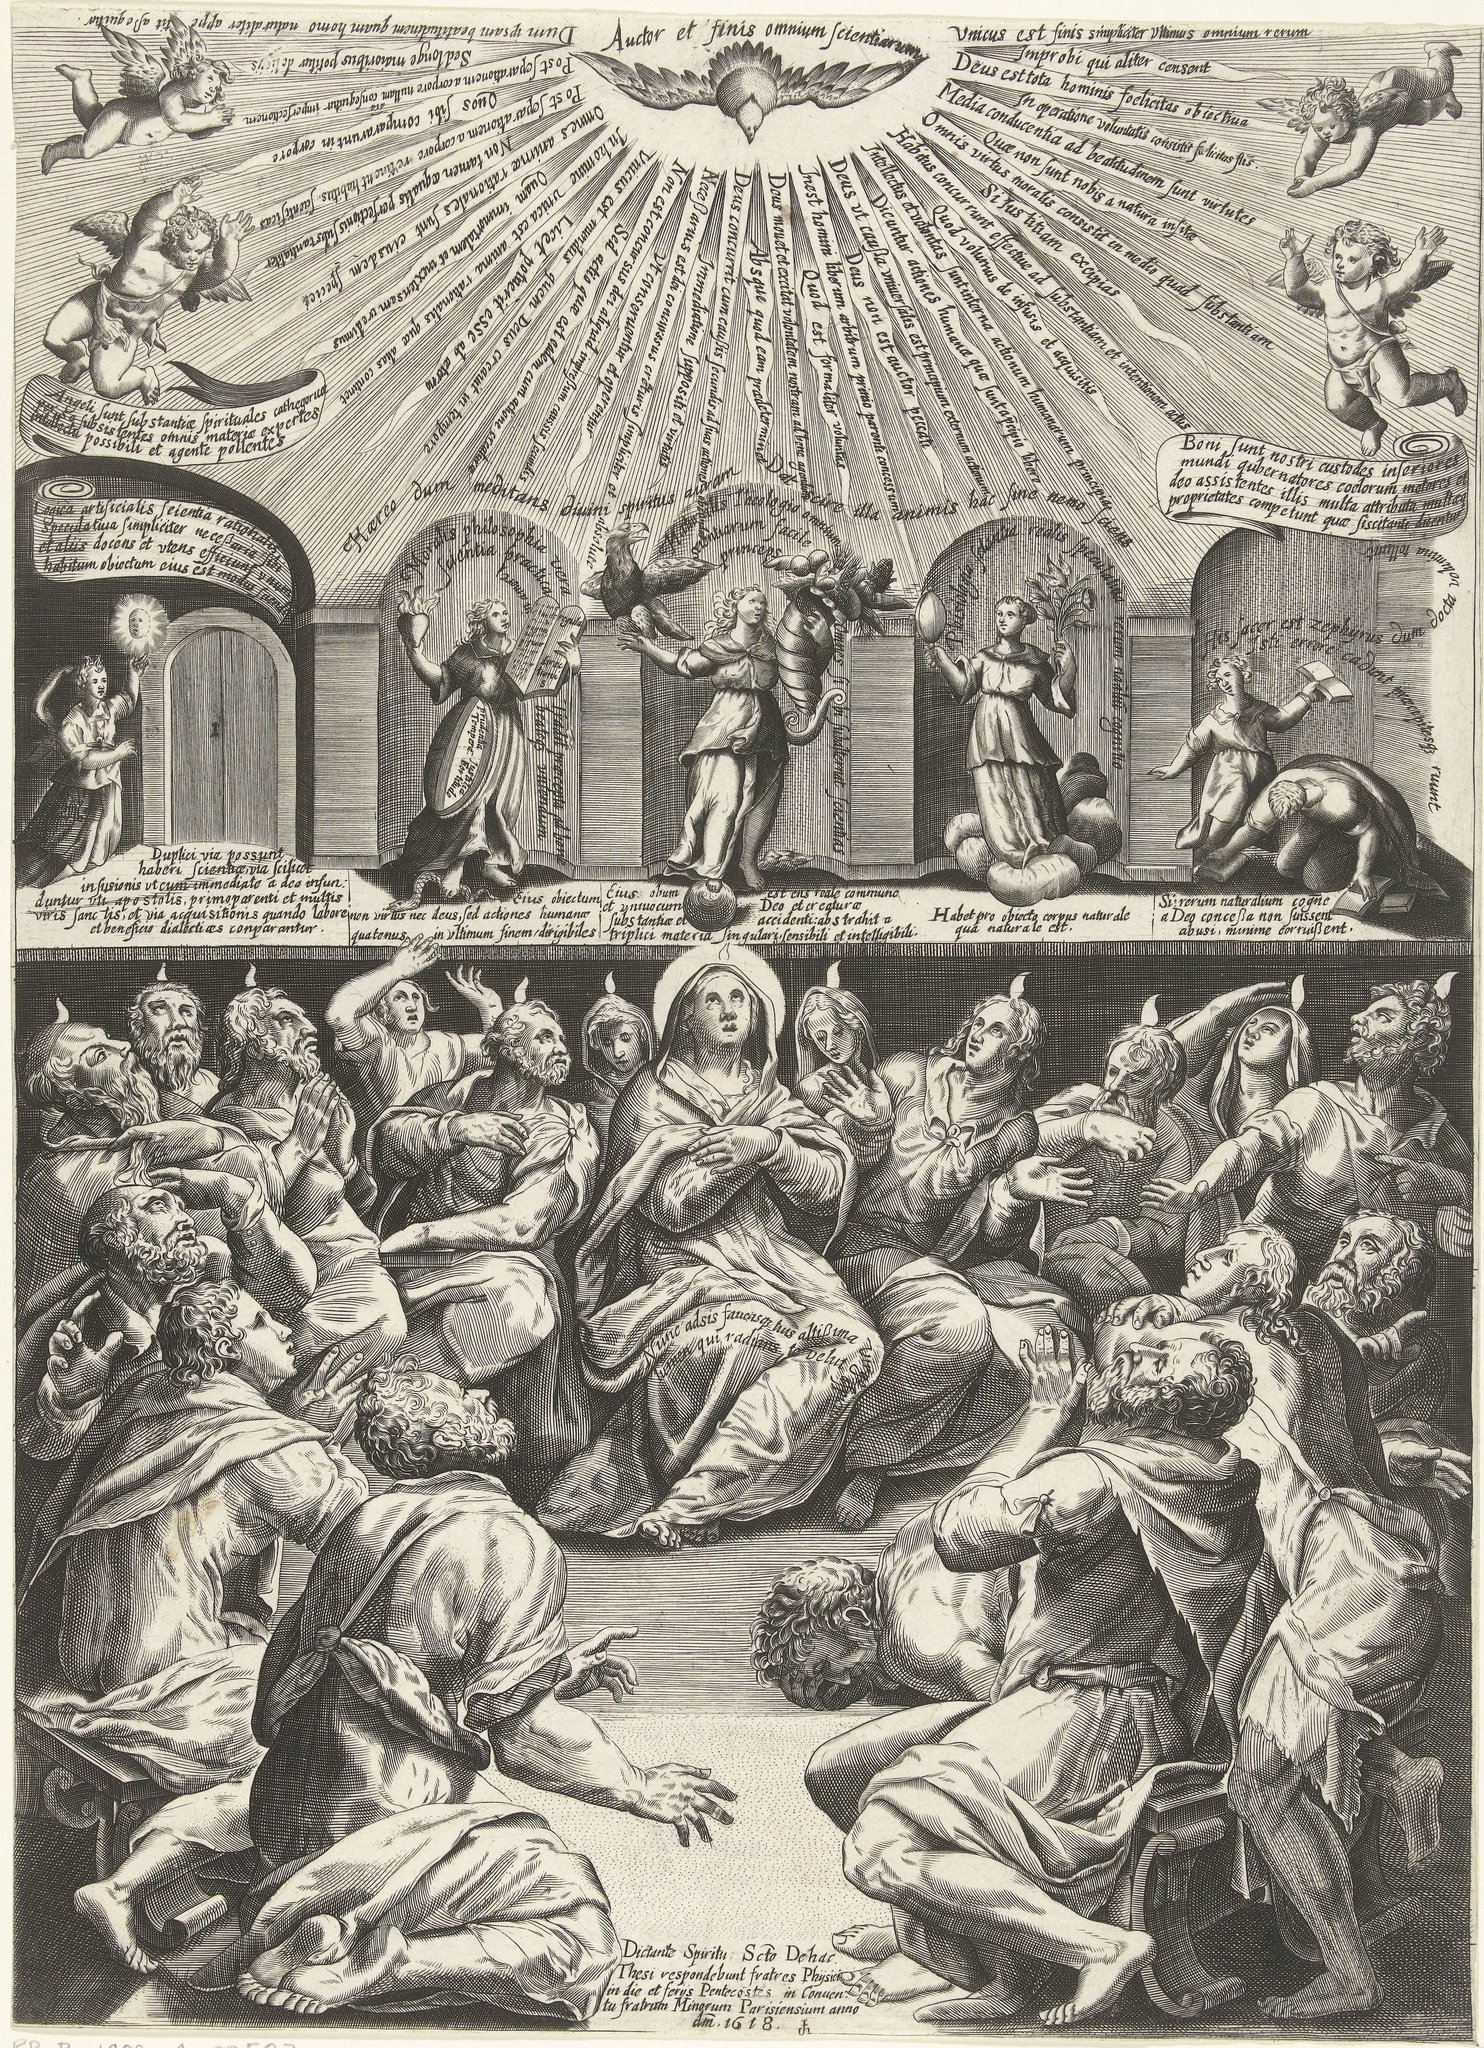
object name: print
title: Uitstorting van de Heilige Geest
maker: jacob van der heyden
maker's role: draughtsman, print maker, publisher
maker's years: 1573-1645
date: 1618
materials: paper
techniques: engraving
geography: rome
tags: pentecost: the holy ghost descends upon (mary and) the apostles, sometimes paul and/or representatives of the nations present (acts 2:1-4)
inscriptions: date: ‘1618’, collector's mark: Lugt 1209, collector's mark: Lugt 2228, caption: ‘Dictante Spiritu S[a]ncto...in Conven: / tu fratrem Minorum Pariseinsium ...’, signature: ‘JH’ Jacob van der Heijden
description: Maria en de apostelen zitten in een tempel in een kring. Door een ronde opening in het dak daalt de H. Geest in de gedaante van een duif op hen neer. Als teken van de H. Geest brandt boven elk hoofd een vlammetje. Op de achtergrond in nissen Wetenschap, Theologie en Natuurkunde met attributen.